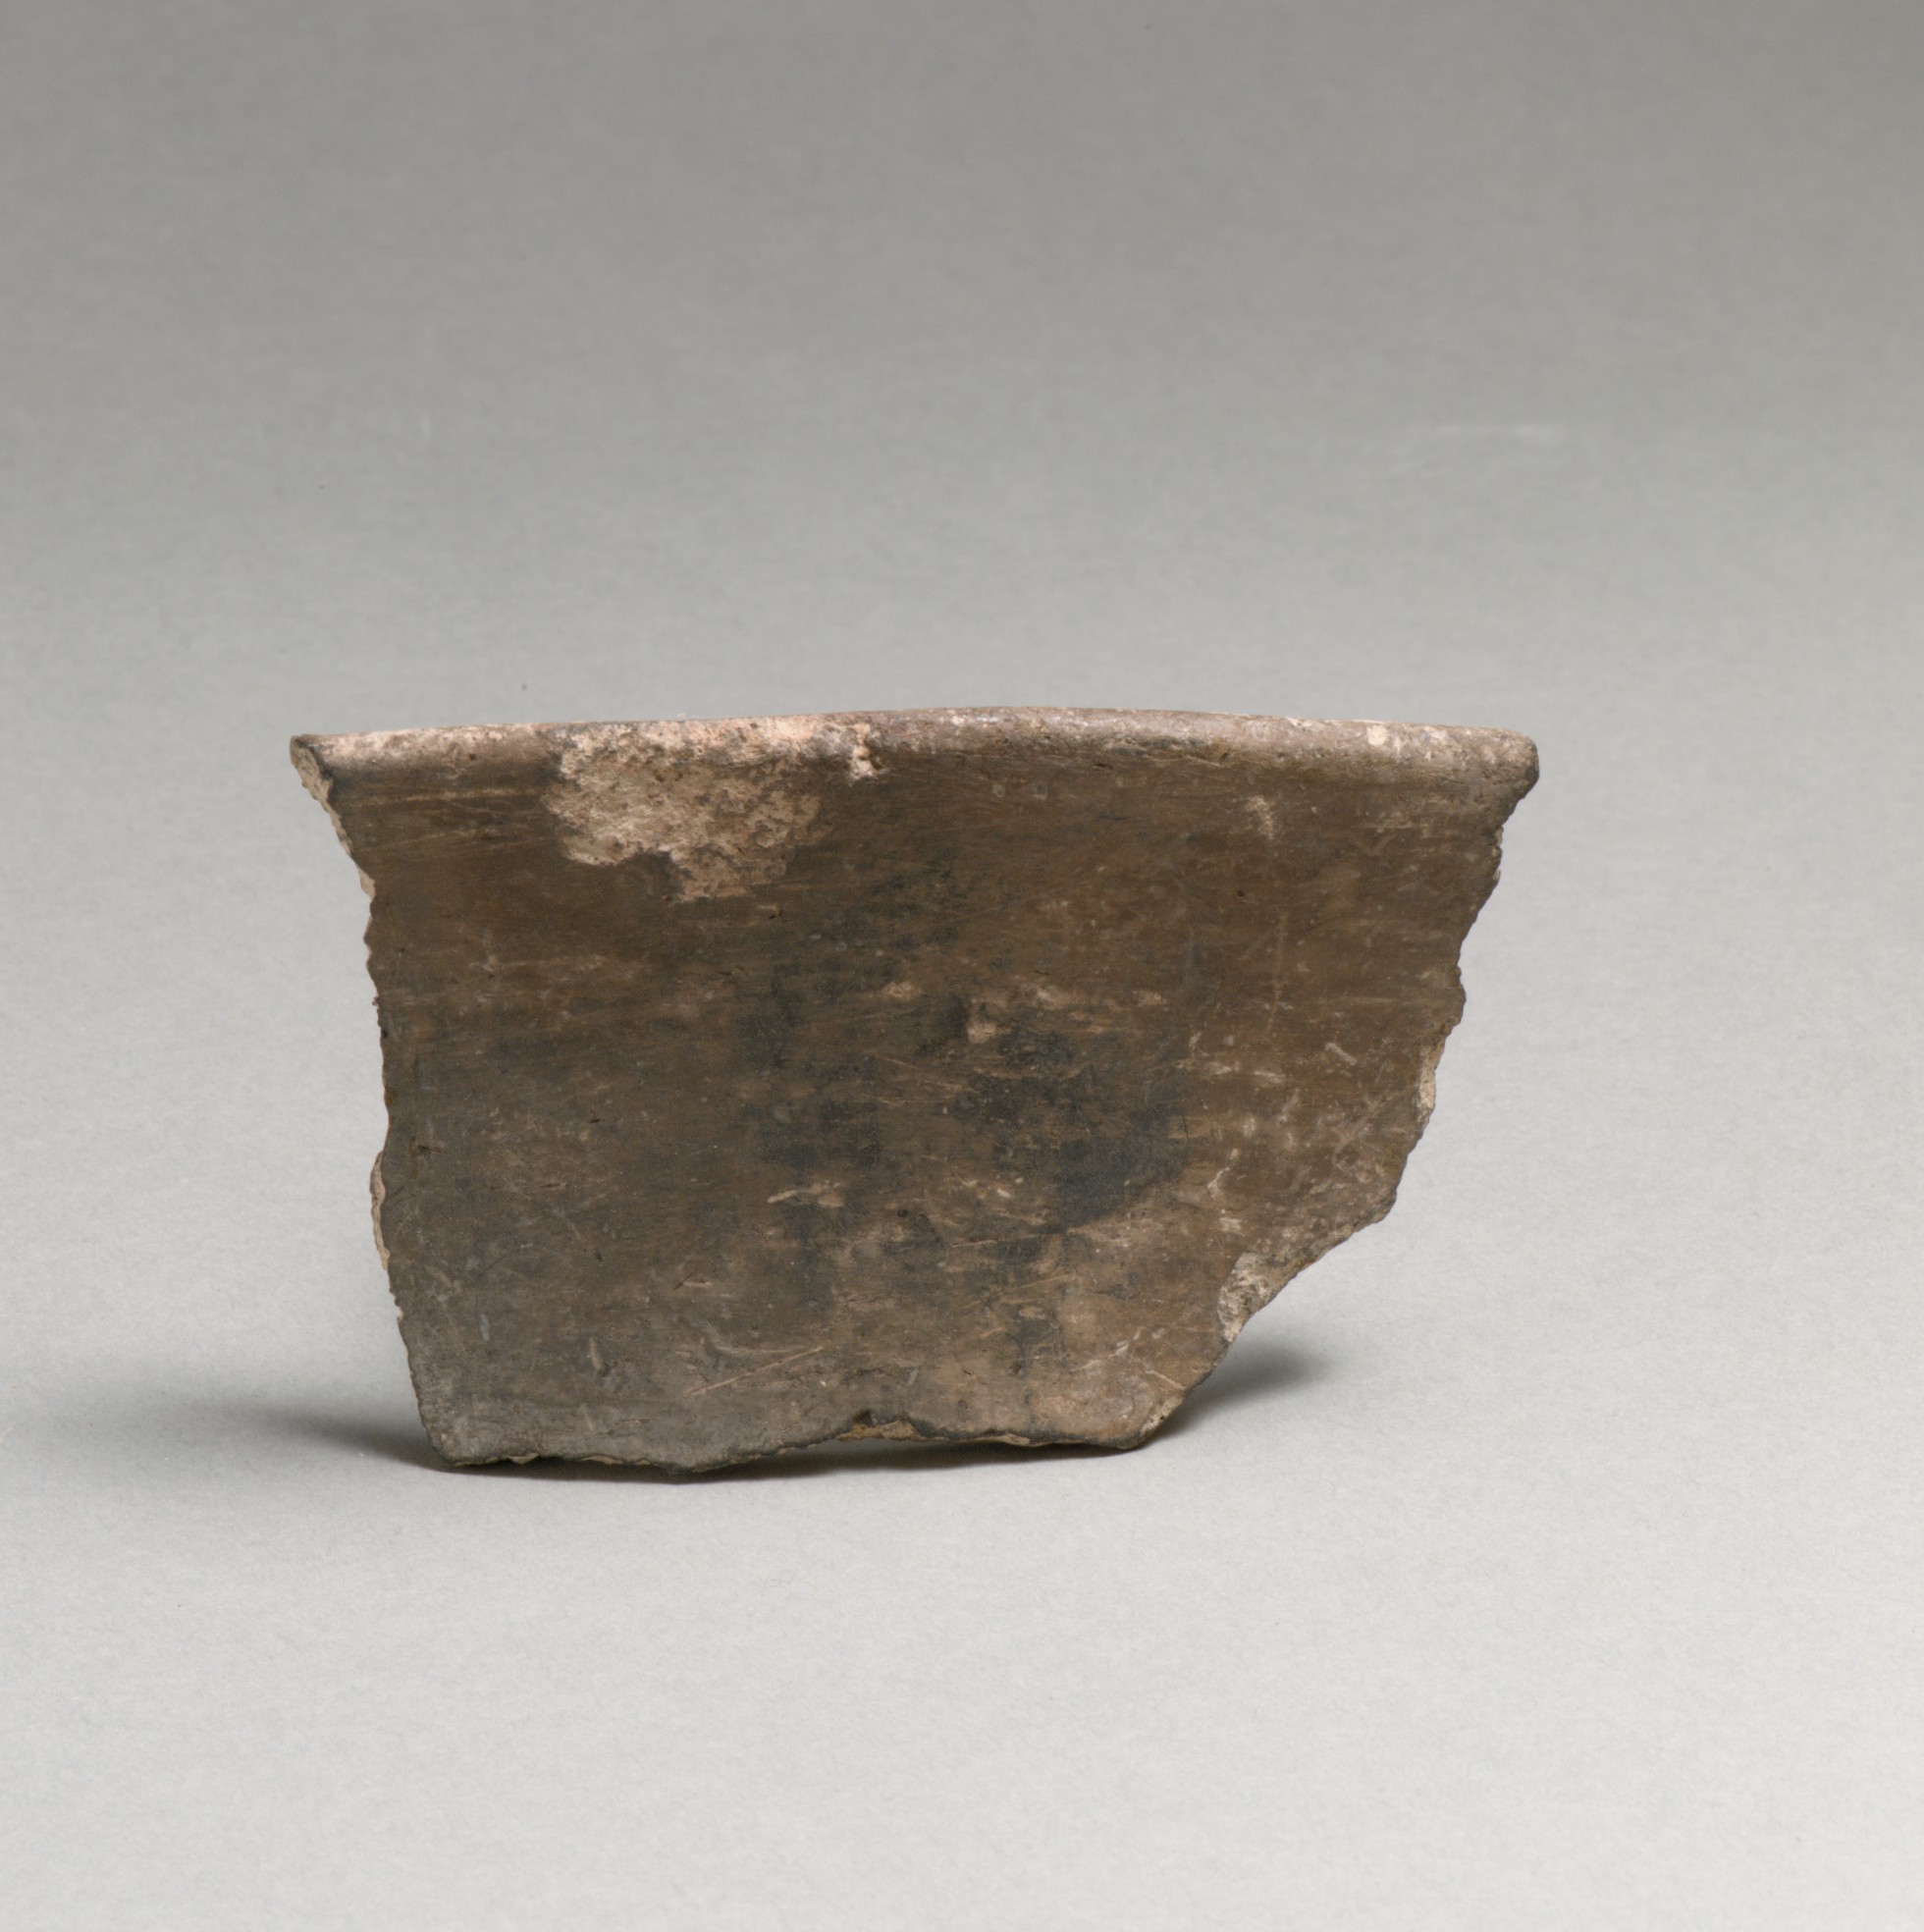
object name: vase fragment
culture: minoan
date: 2600-2000 BCE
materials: terracotta